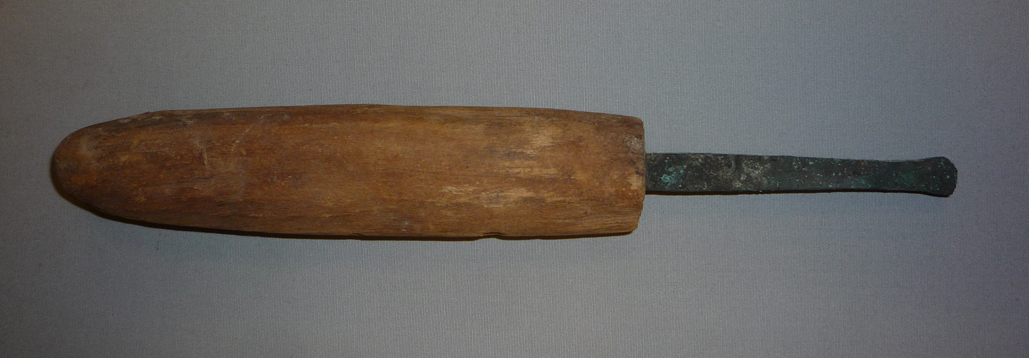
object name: chisel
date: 1550-1295 BCE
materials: bronze, copper alloy, wood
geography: egypt